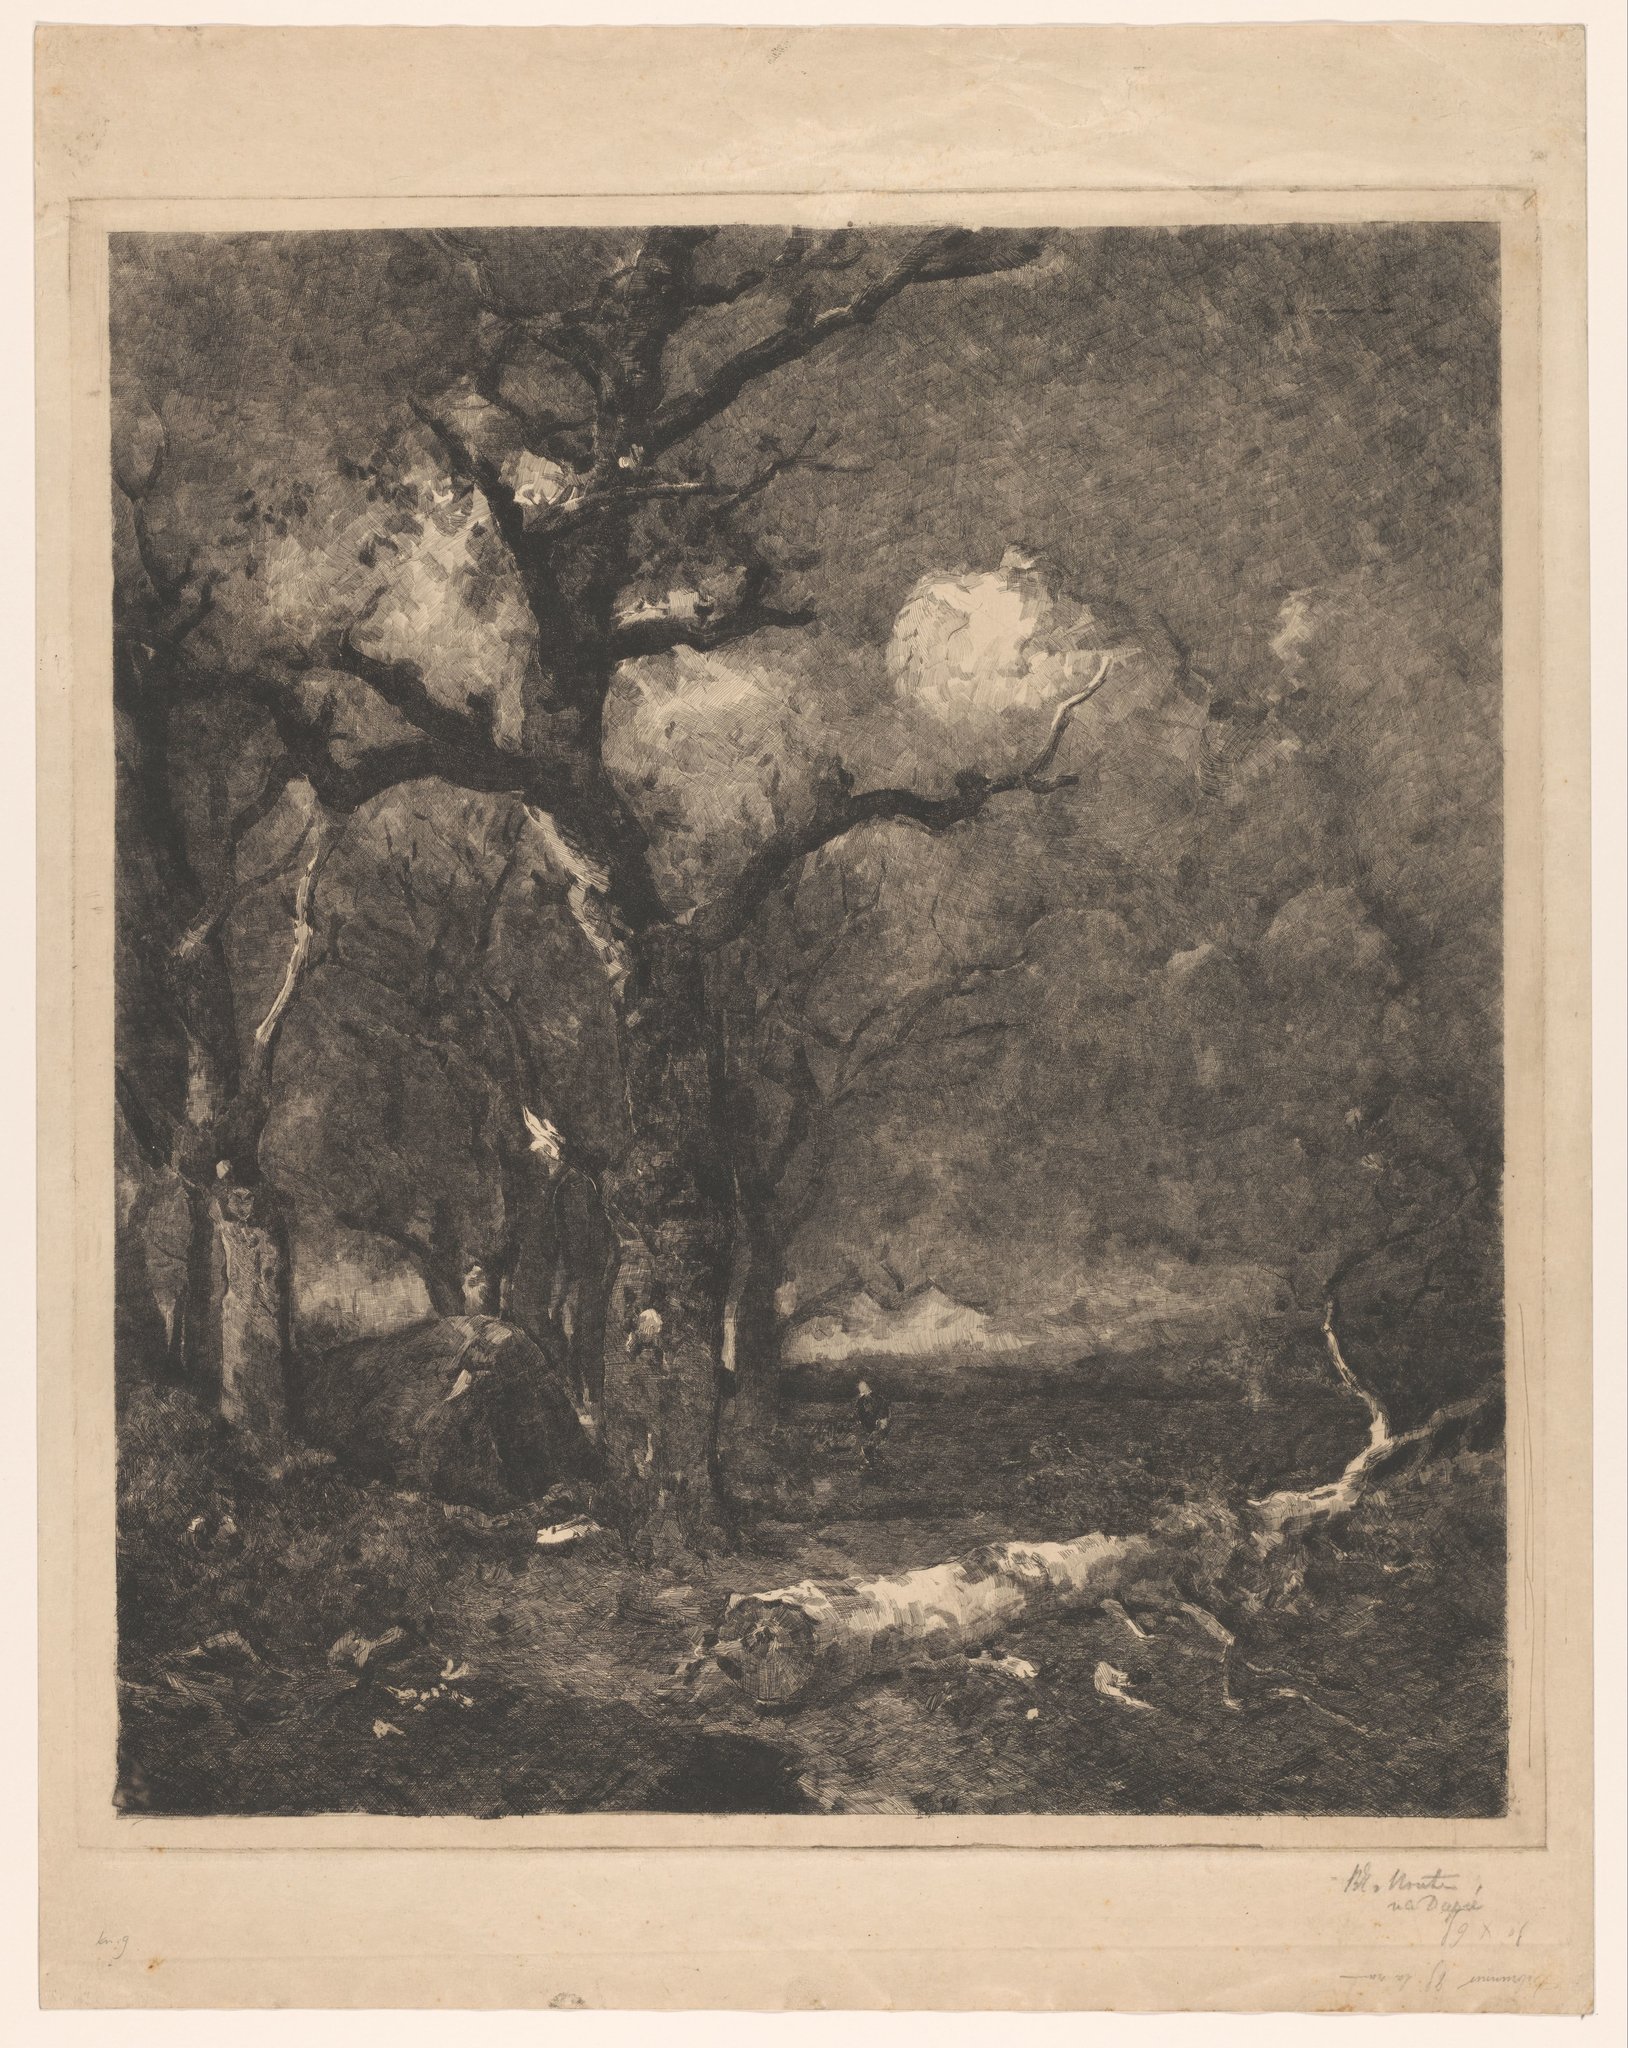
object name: print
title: Herfstlandschap met boom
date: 1872-1950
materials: paper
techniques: etching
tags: trees, landscapes in the temperate zone, autumn landscape; landscape symbolizing autumn (the four seasons of the year)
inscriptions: collector's mark: Lugt 2228, inscription: ‘Debrun[...]’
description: Prent naar het schilderij 'Herfst' van Jules Dupré uit ca. 1865.